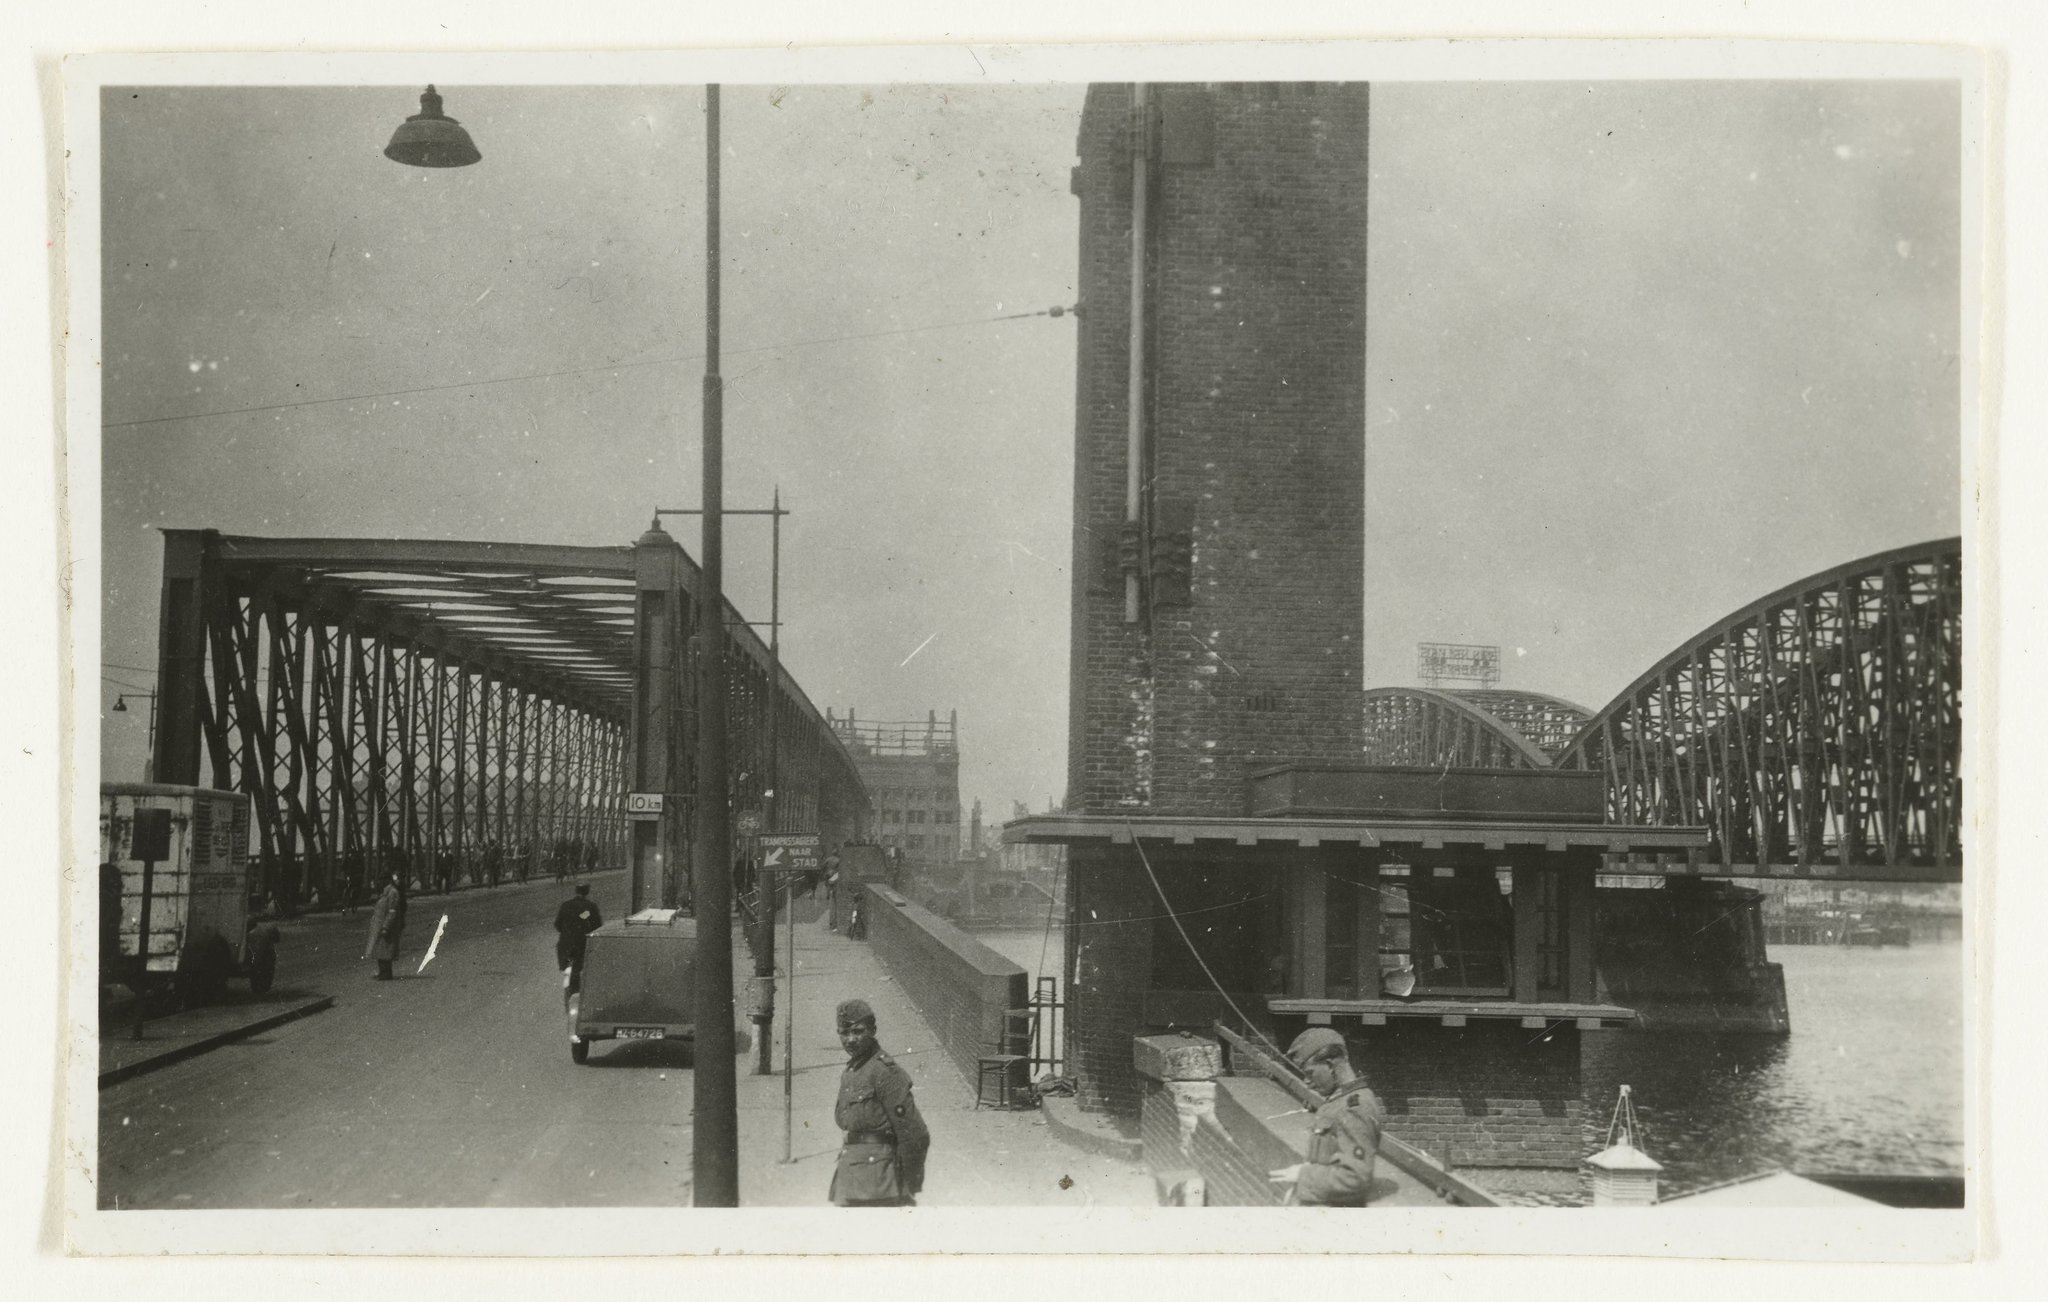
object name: photograph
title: Twee bruggen in Rotterdam.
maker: Anonymous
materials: photographic support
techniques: gelatin silver print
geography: rotterdam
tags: bridge, occupation ~ war, rotterdam, rotterdam blitz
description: Twee bruggen over de Maas, een is een boogbrug. Op de voorgrond twee Duitse soldaten